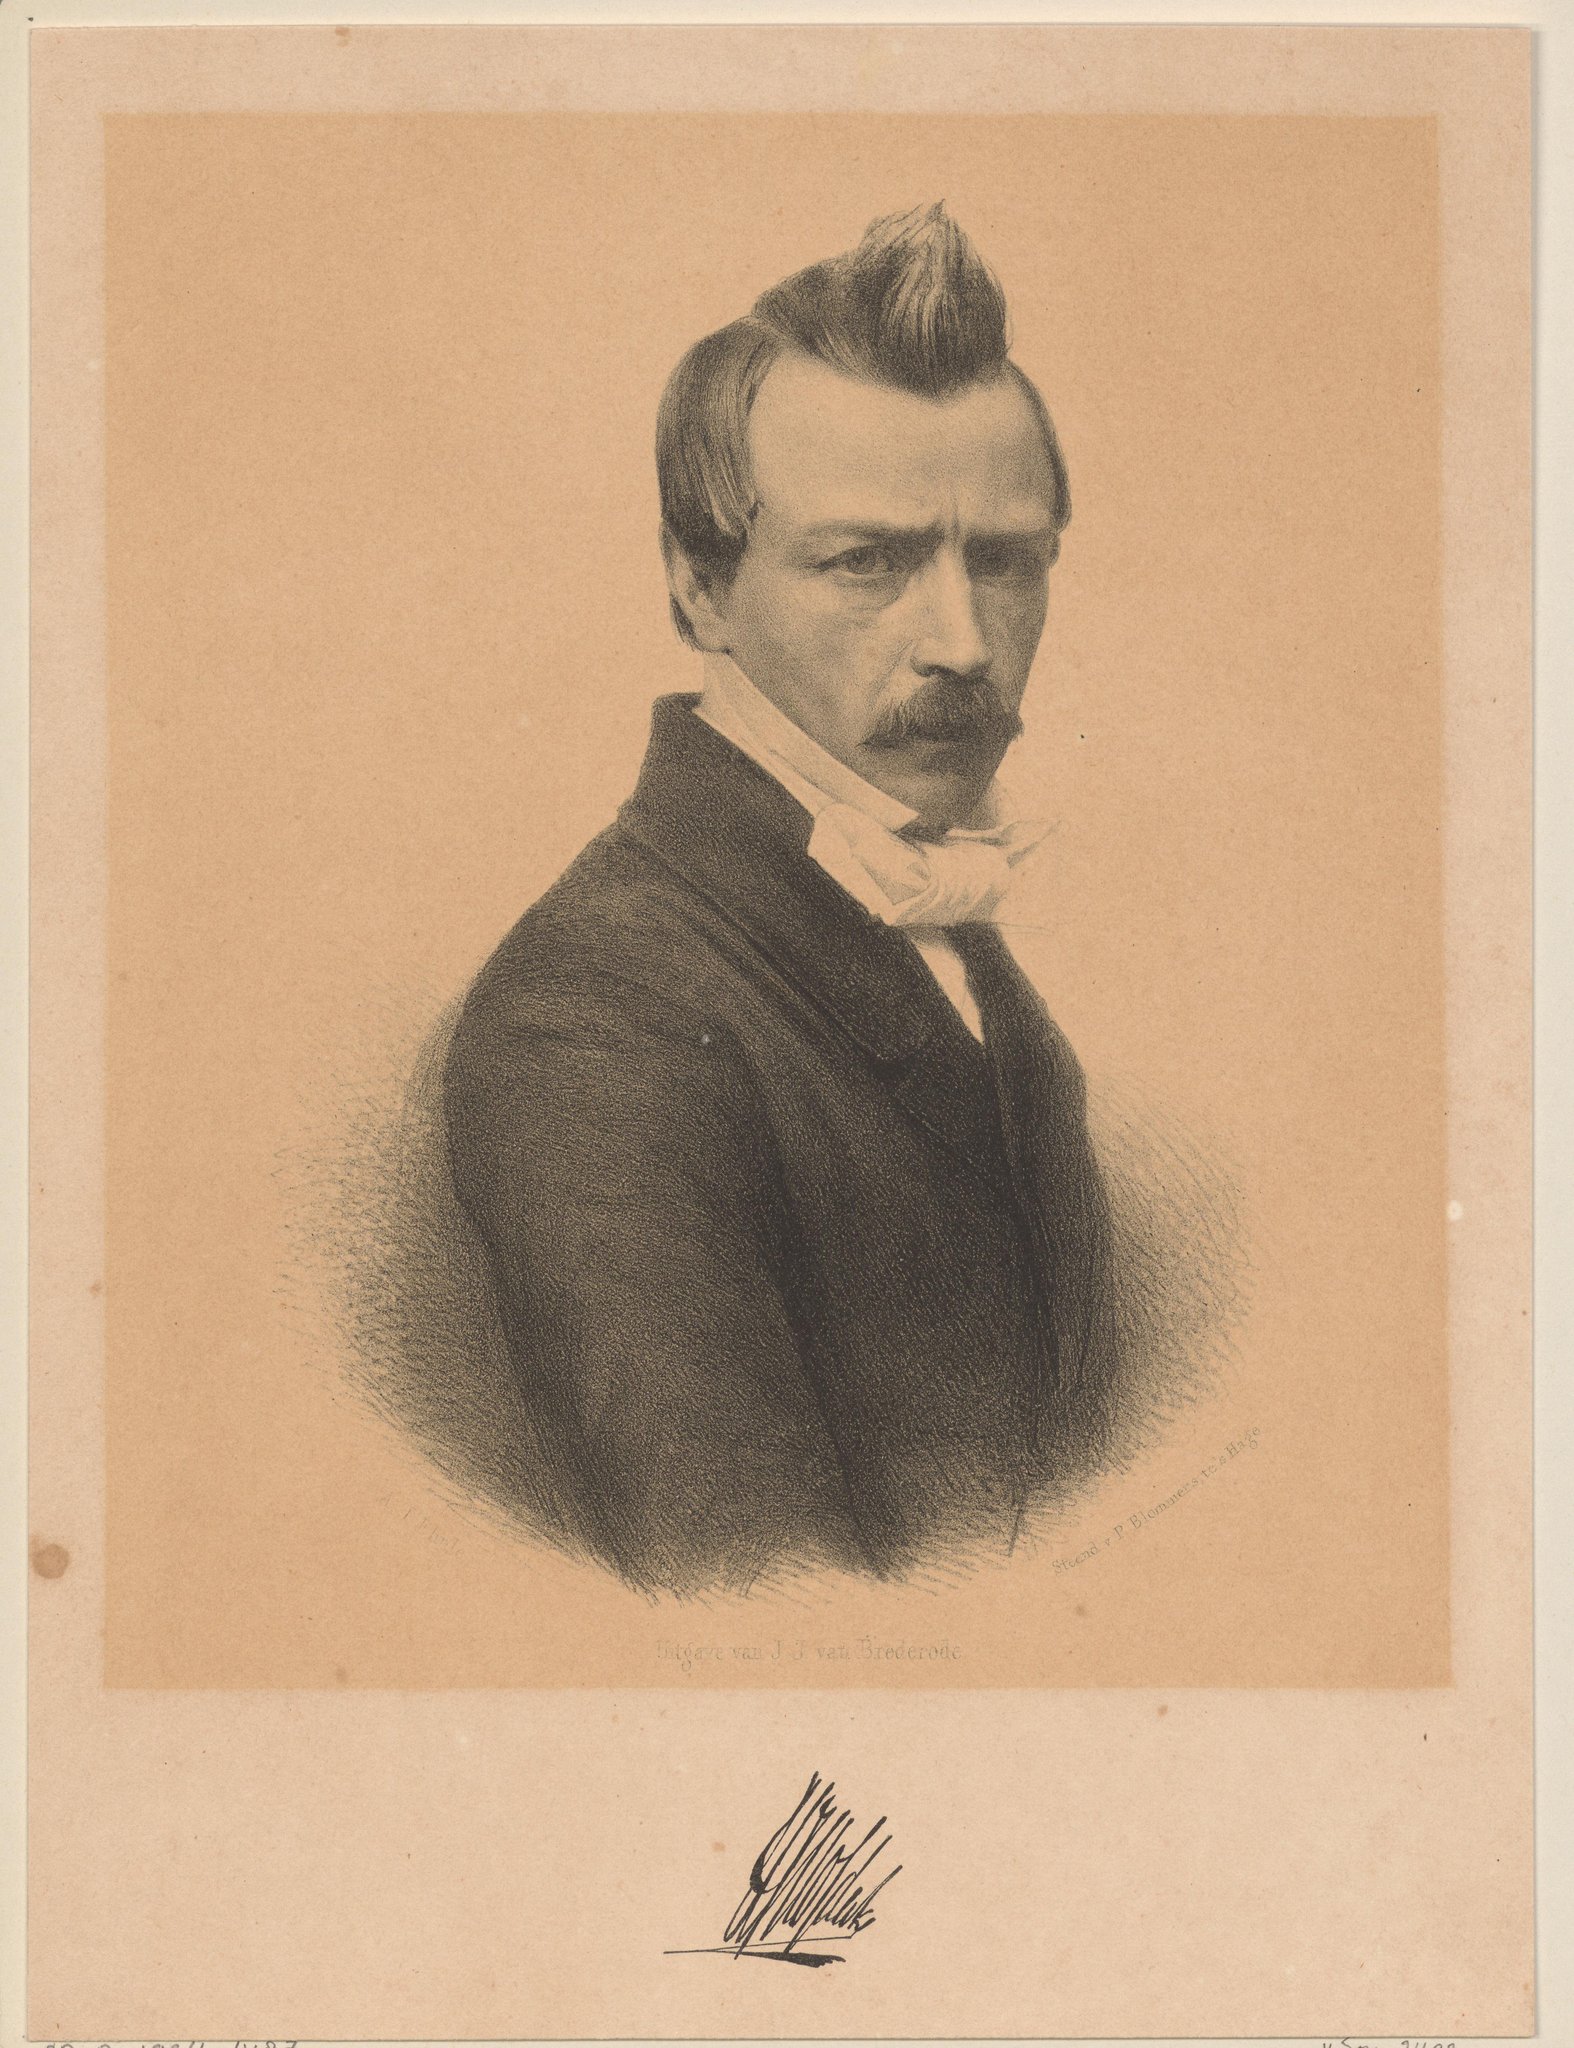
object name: print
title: Portret van Willem Jacobs Hofdijk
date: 1847-1863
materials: paper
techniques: tone lithography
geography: haarlem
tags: arnhem, historical persons, writer, poet, author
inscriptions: collector's mark: Lugt 2228